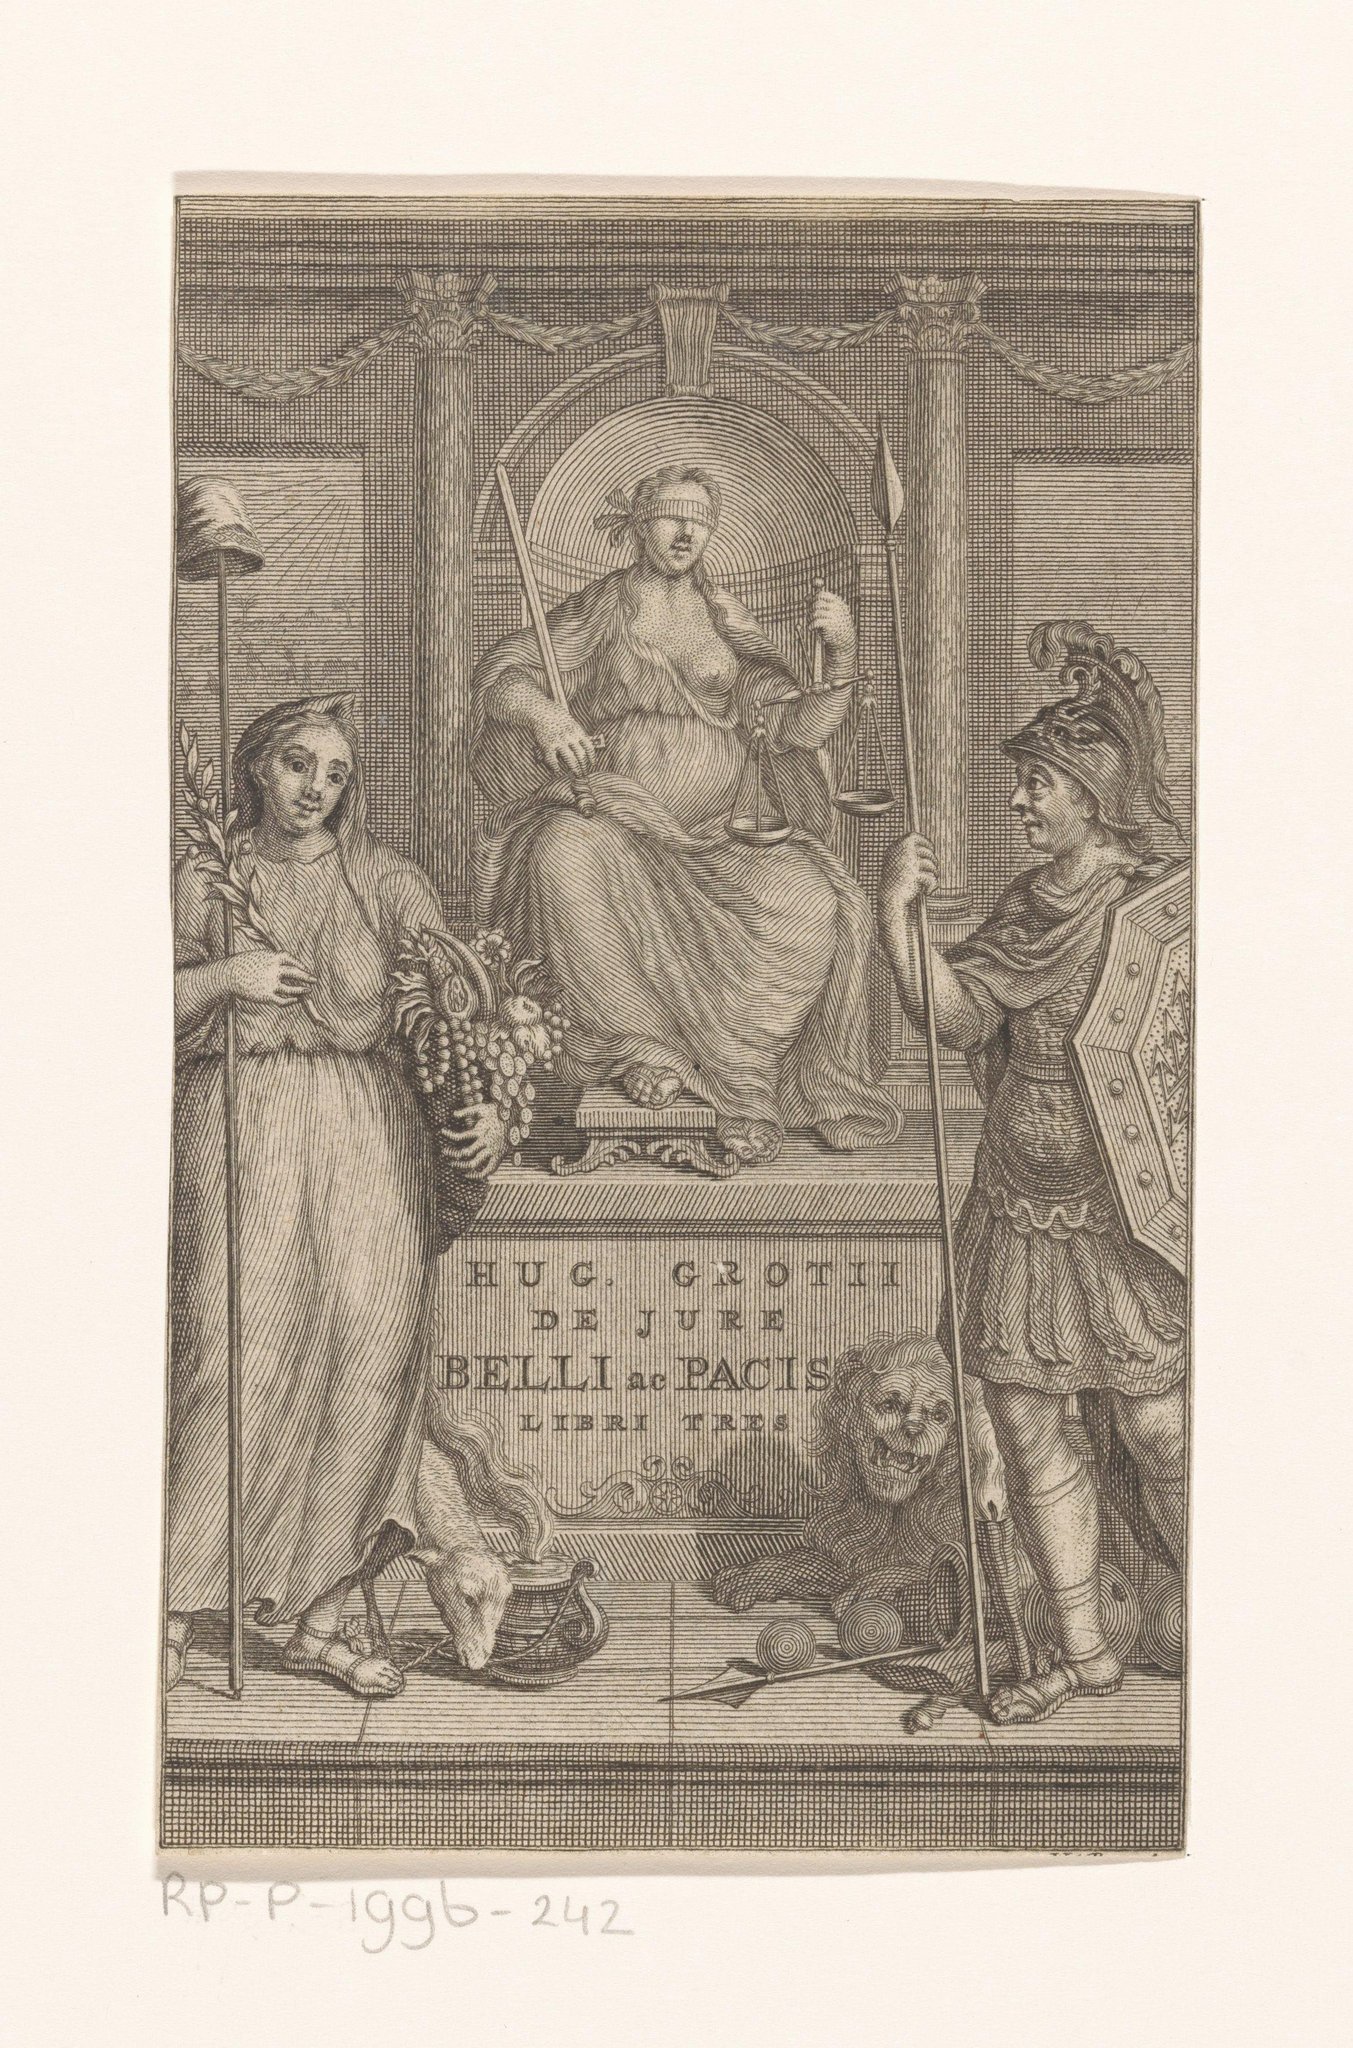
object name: titelblad, titelpagina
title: Justitia zittend op haar troon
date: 1712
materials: paper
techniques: engraving, etching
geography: amsterdam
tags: justice; 'forza alla giustitia sottoposta', 'giustitia', 'giustitia retta', 'giustitia rigorosa', 'impietà e violenza soggetta alla giustitia' (ripa), freedom, liberty; 'libertà' (ripa)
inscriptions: collector's mark: Lugt 2760, collector's mark: Lugt 2228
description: Justitia zit geblinddoekt op haar troon, met weegschaal en zwaard in haar hand. Links van haar staat Vrijheid met vrijheidshoed, hoorn des overvloeds en een lam. Rechts staat een soldaat met wapens en een leeuw aan zijn voeten.